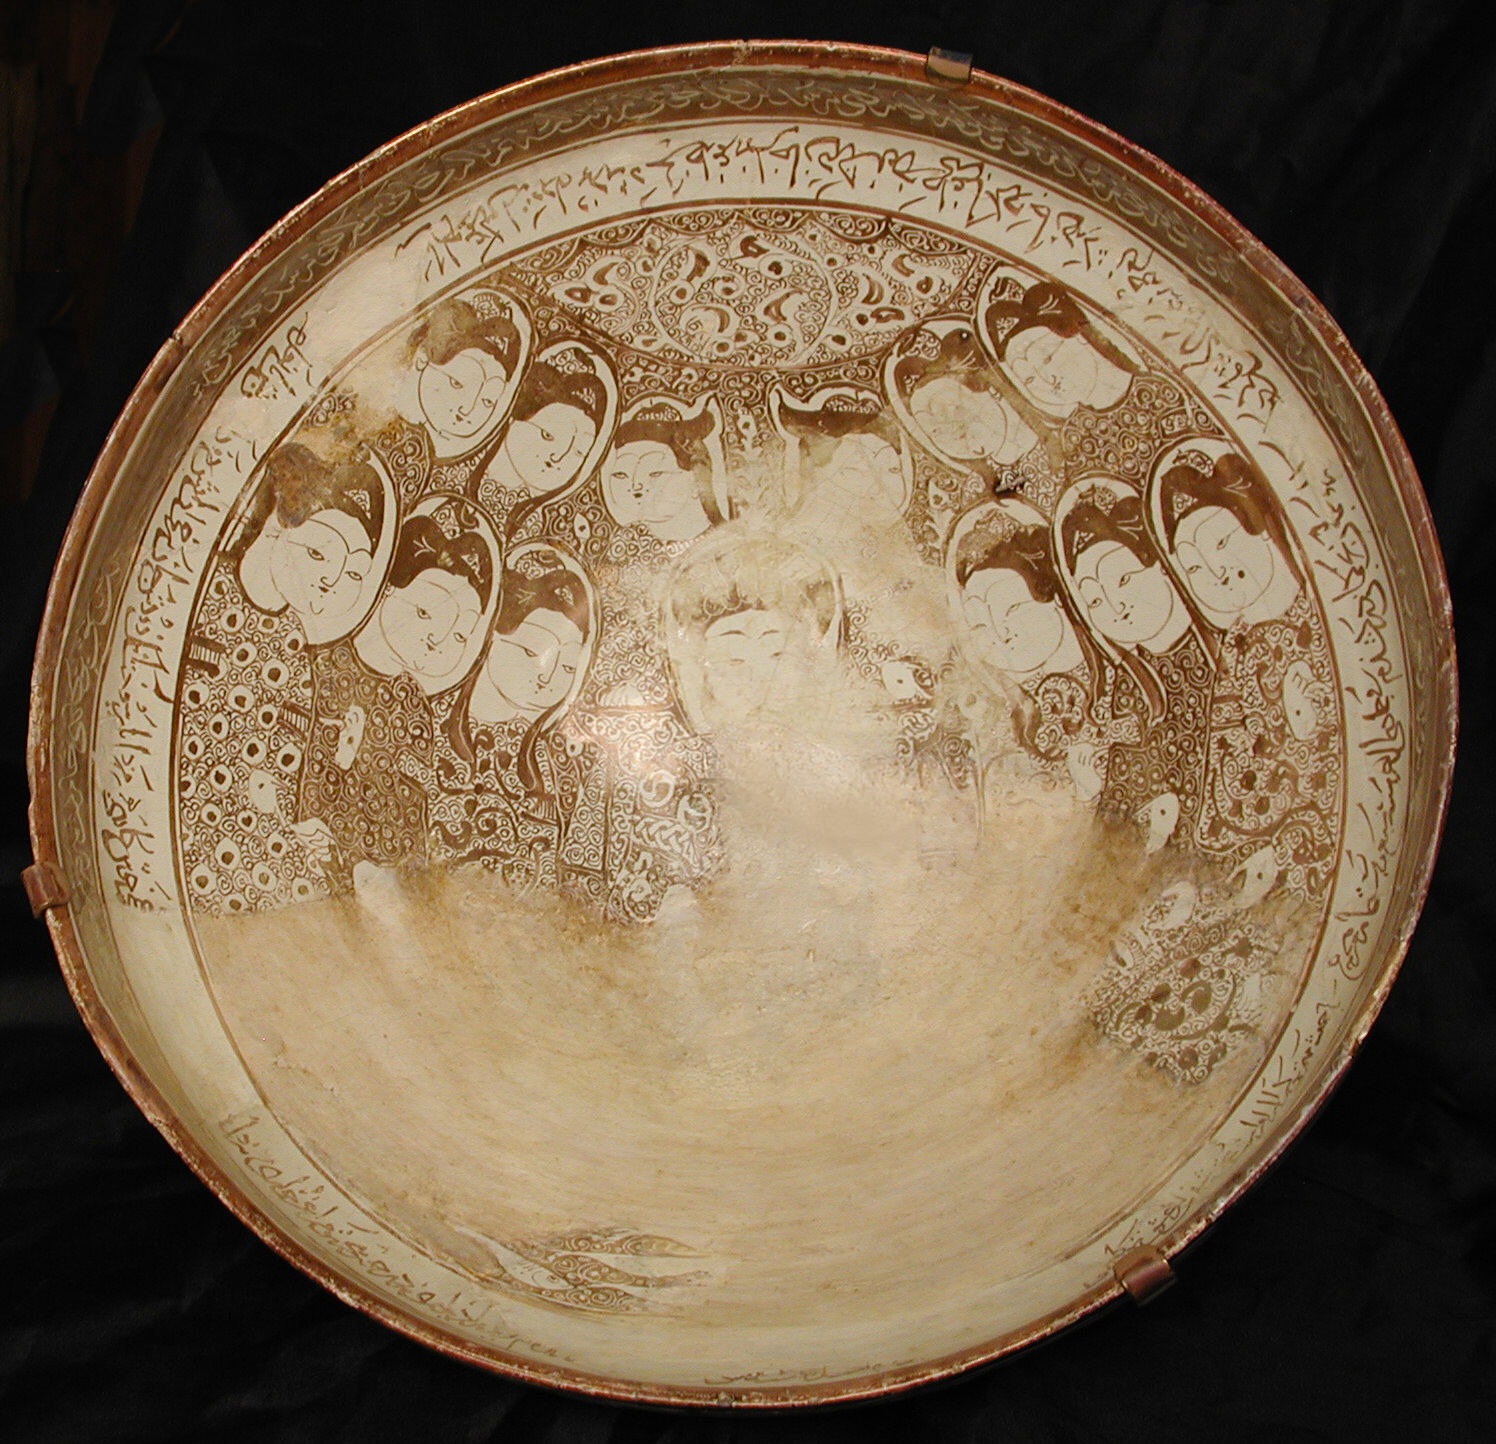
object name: bowl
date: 1201-1300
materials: glaze, stonepaste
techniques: luster painting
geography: iran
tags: faces